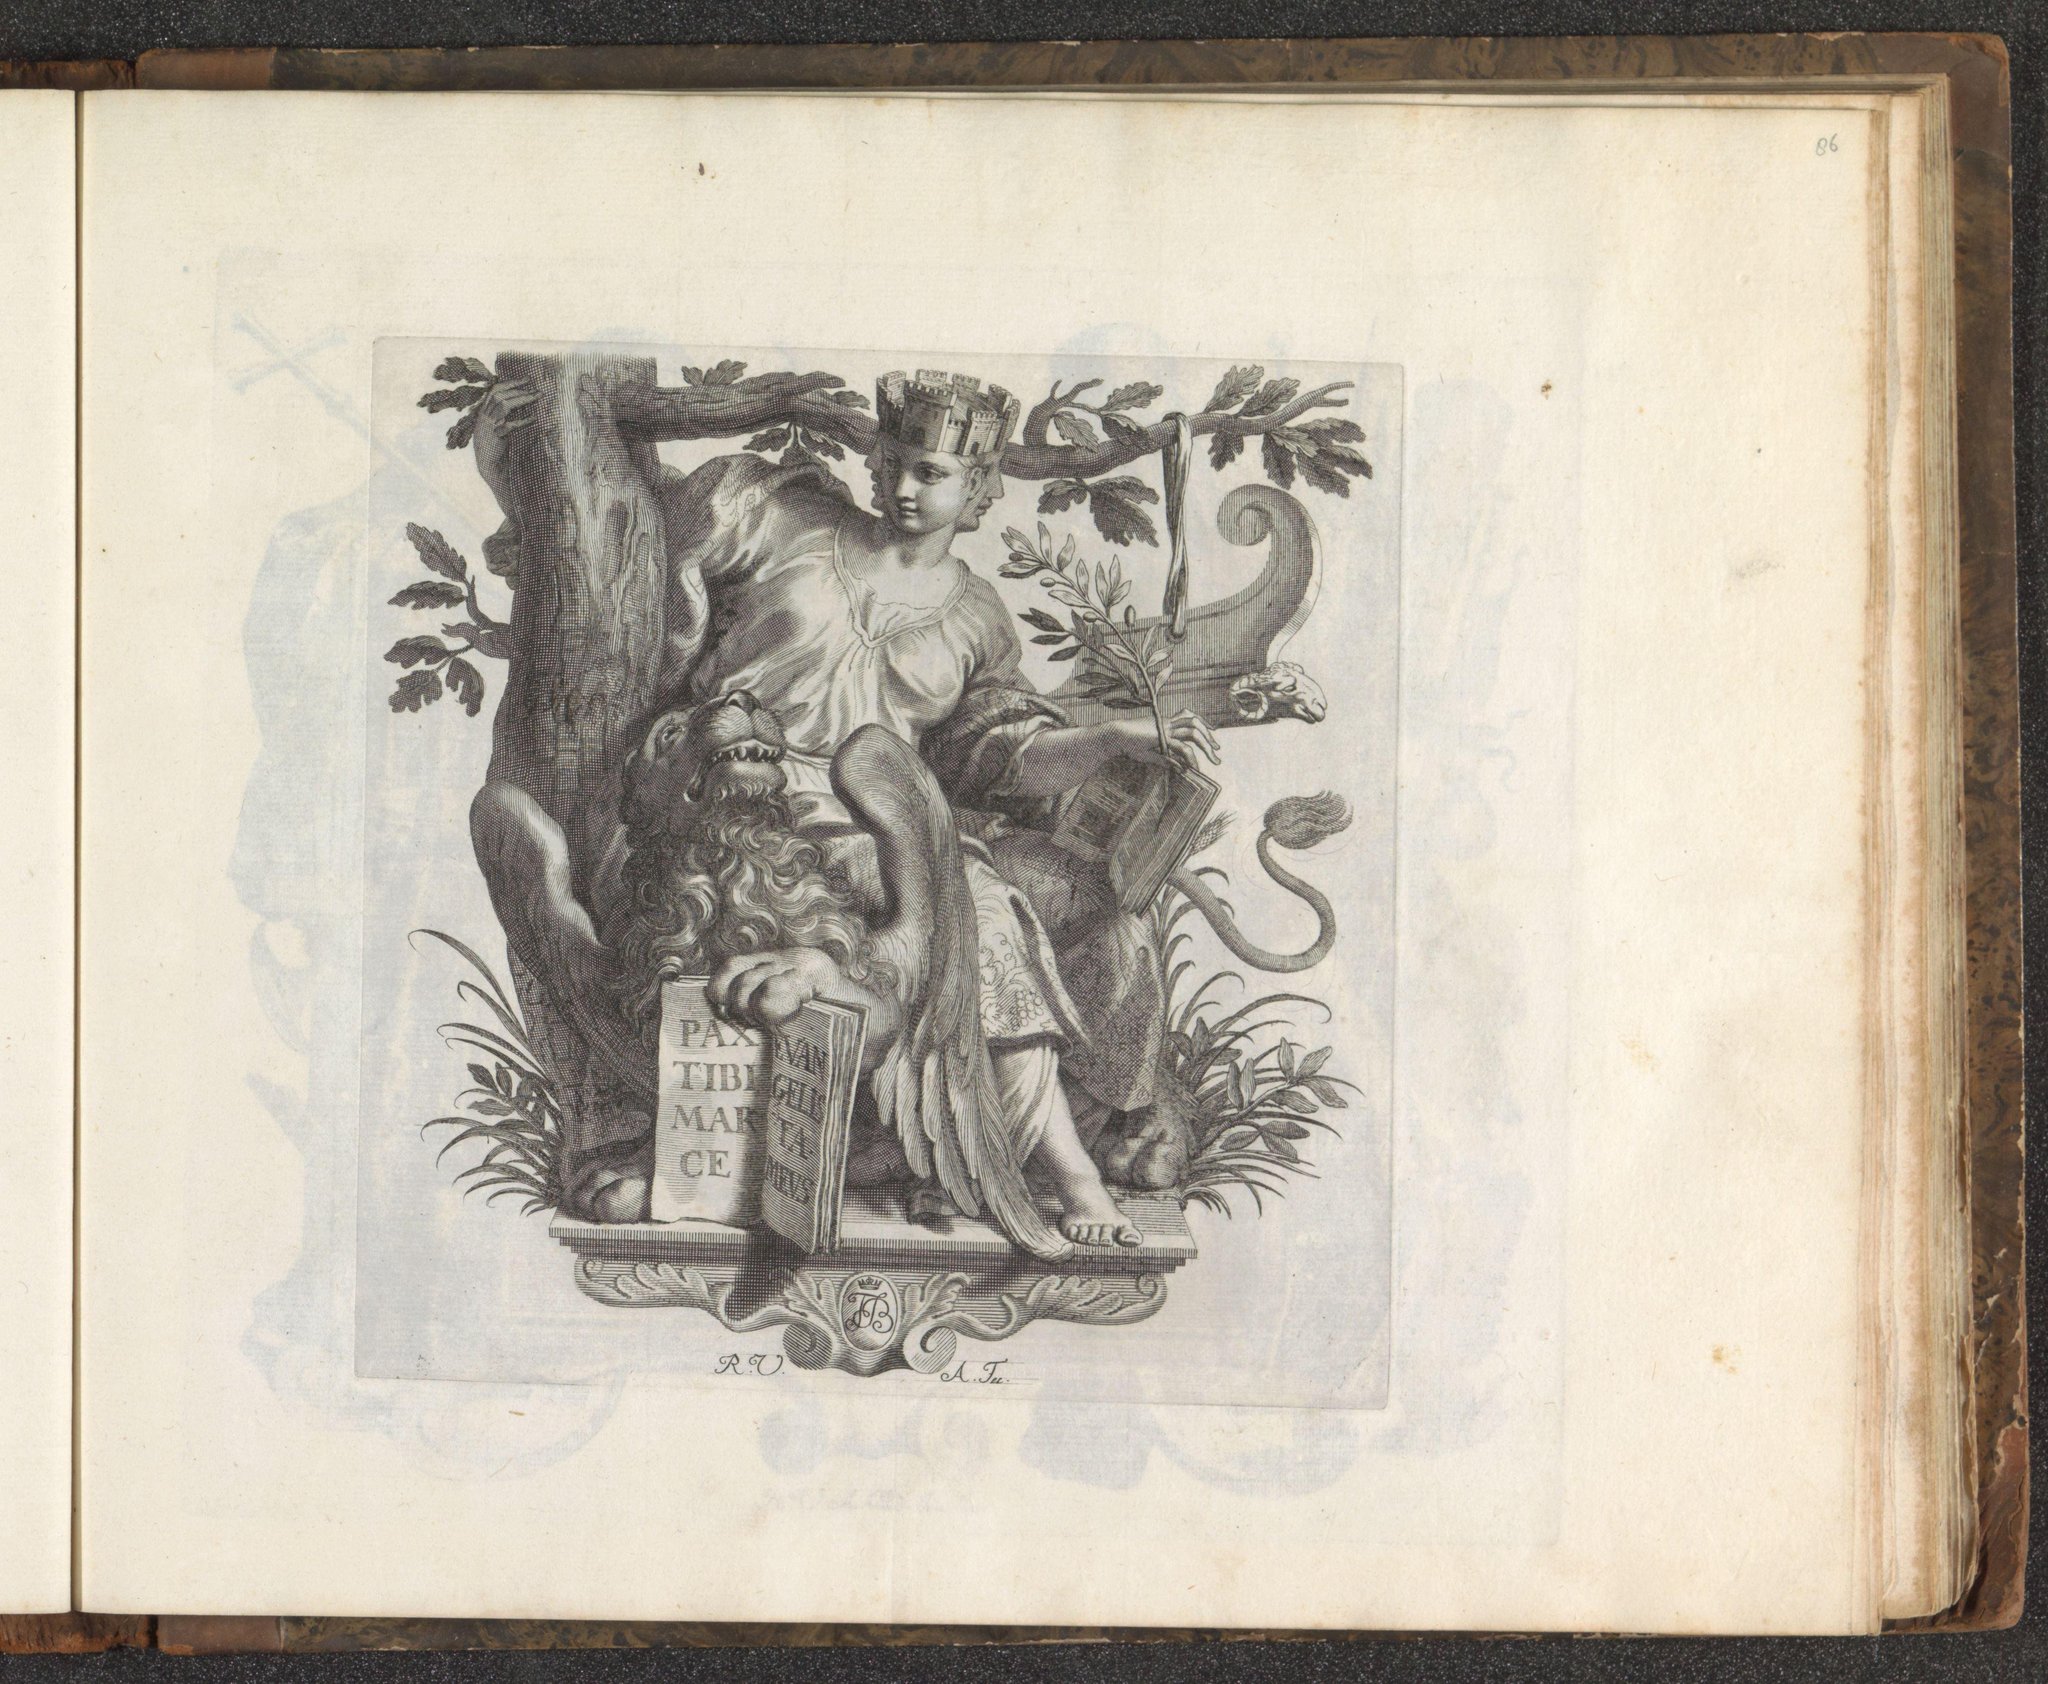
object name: print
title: Personificatie van de provincie Marca Trevigiana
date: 1673-1743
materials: paper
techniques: engraving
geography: rome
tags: personifications of countries, nations, states, districts, etc., lion (possibly with book) ~ symbol of st. mark, janus' head, two-faced head, venice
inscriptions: collector's mark: Lugt 2228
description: Een vrouw met drie gezichten met op haar hoofd een muurkroon en op haar kleding versiering van wijnranken. Ze zit op de rug van een gevleugelde leeuw (de leeuw van Sint Marcus) en heeft met haar rechterhand een eikenboom vast. Aan de eikenboom hangt rechts een scheepsromp. In haar linkerhand heeft de vrouw een boek en een olijftak. De prent maakt deel uit van een album.